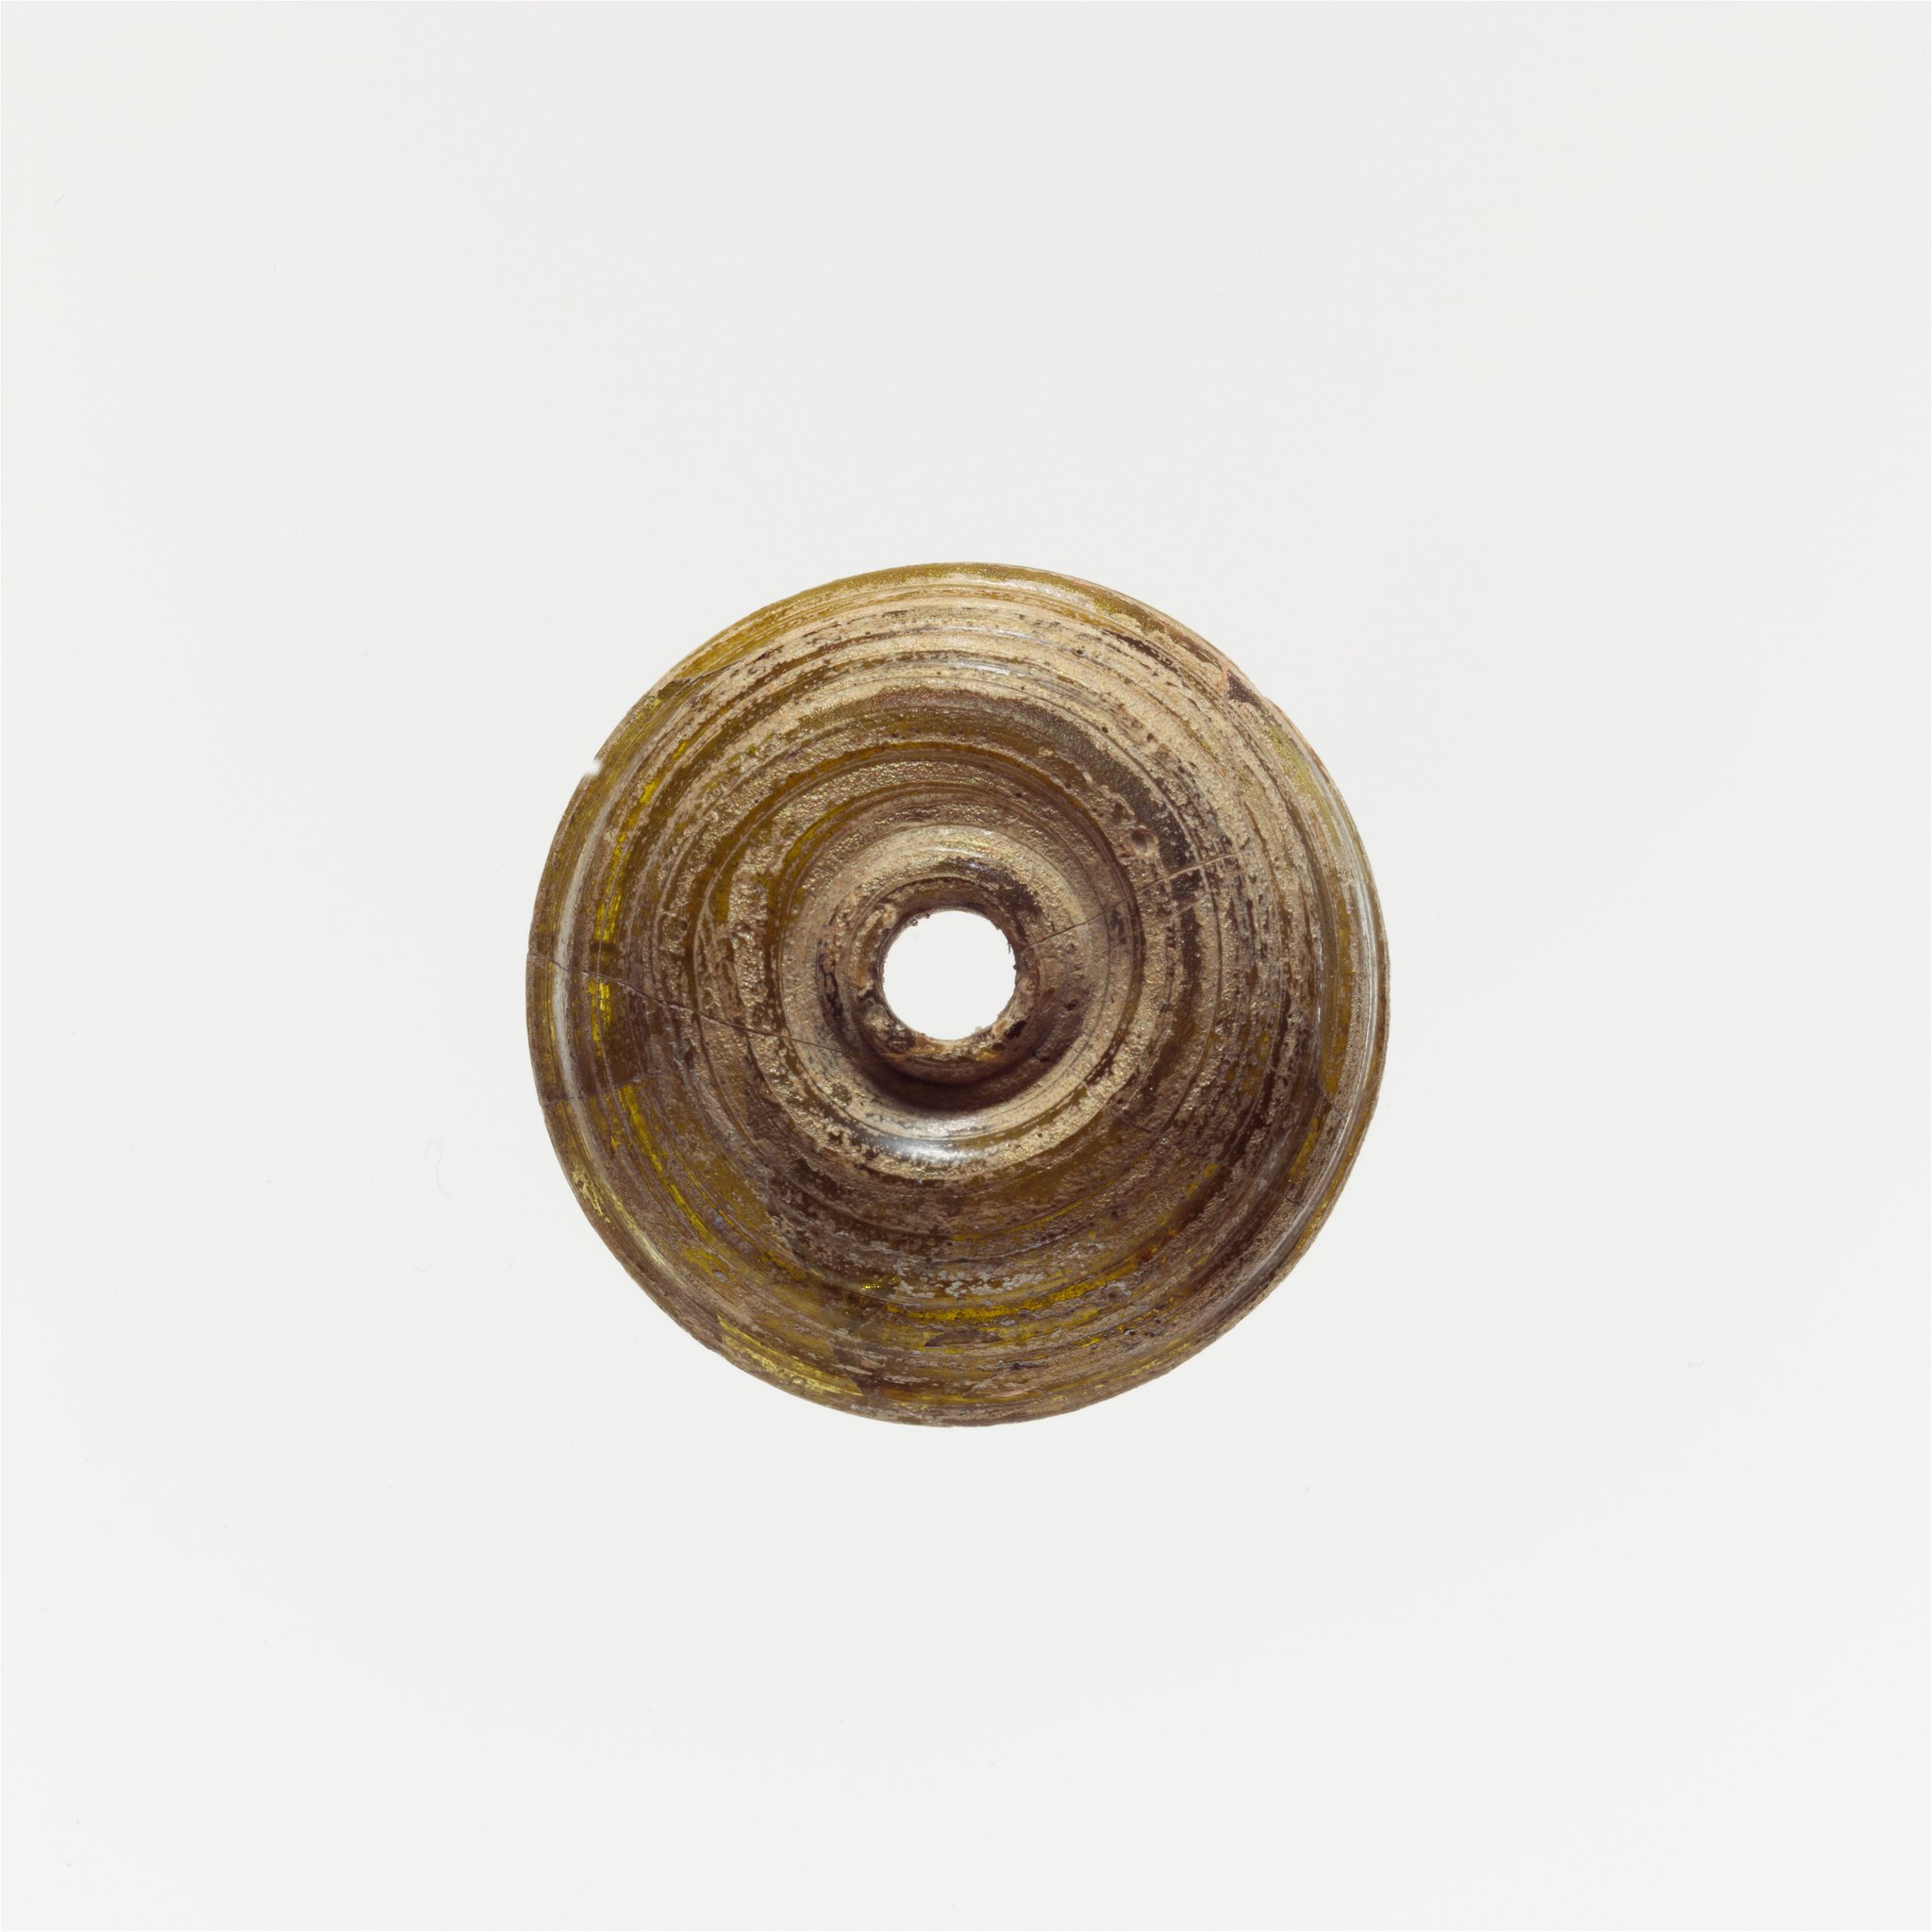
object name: spindle whorl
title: Glass spindle whorl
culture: roman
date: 1-200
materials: glass